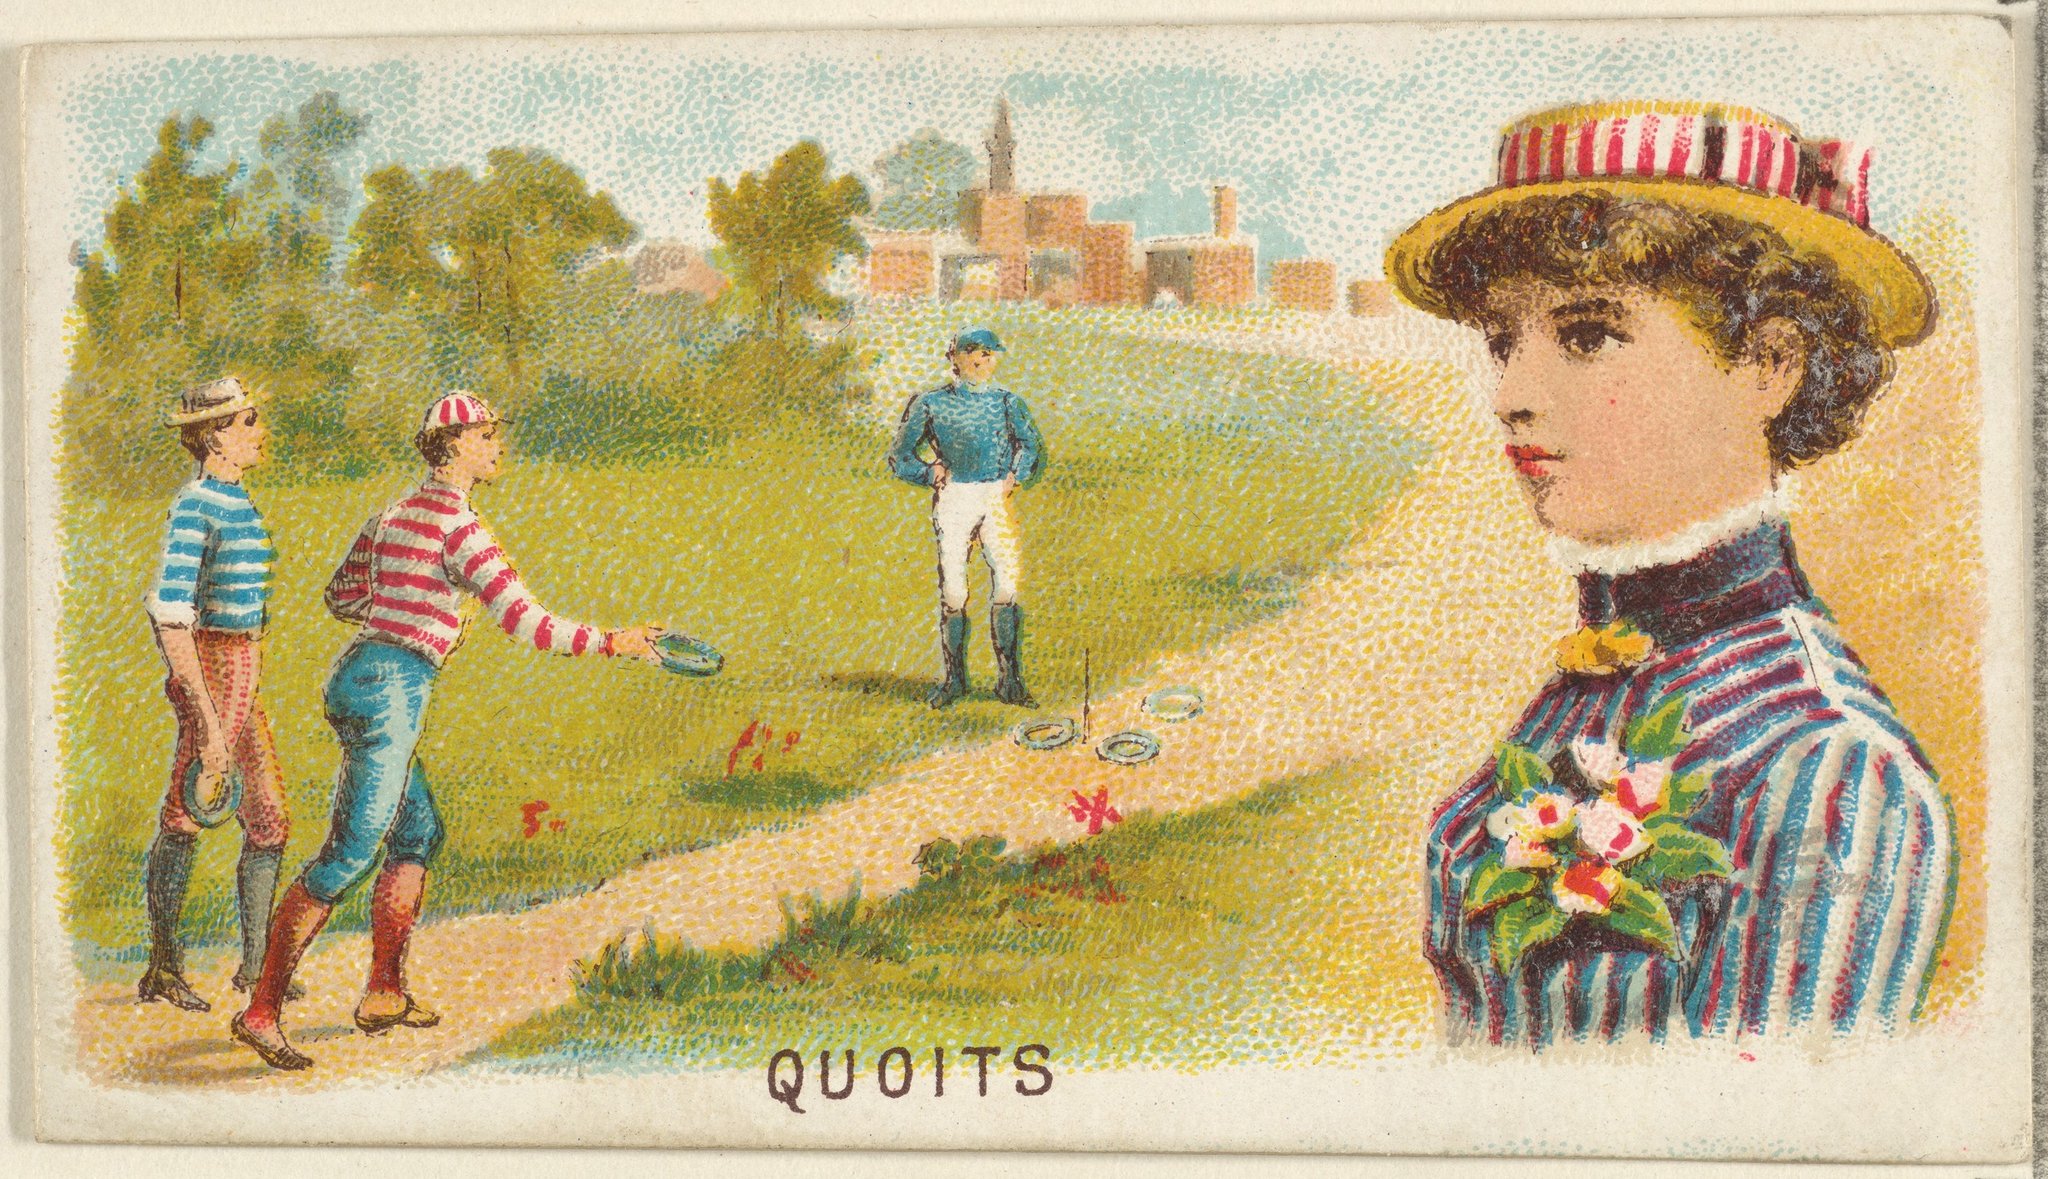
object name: print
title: Quoits, from the Games and Sports series (N165) for Old Judge Cigarettes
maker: goodwin & company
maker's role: publisher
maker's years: 1850-1950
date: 1889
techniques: color lithograph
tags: men,women